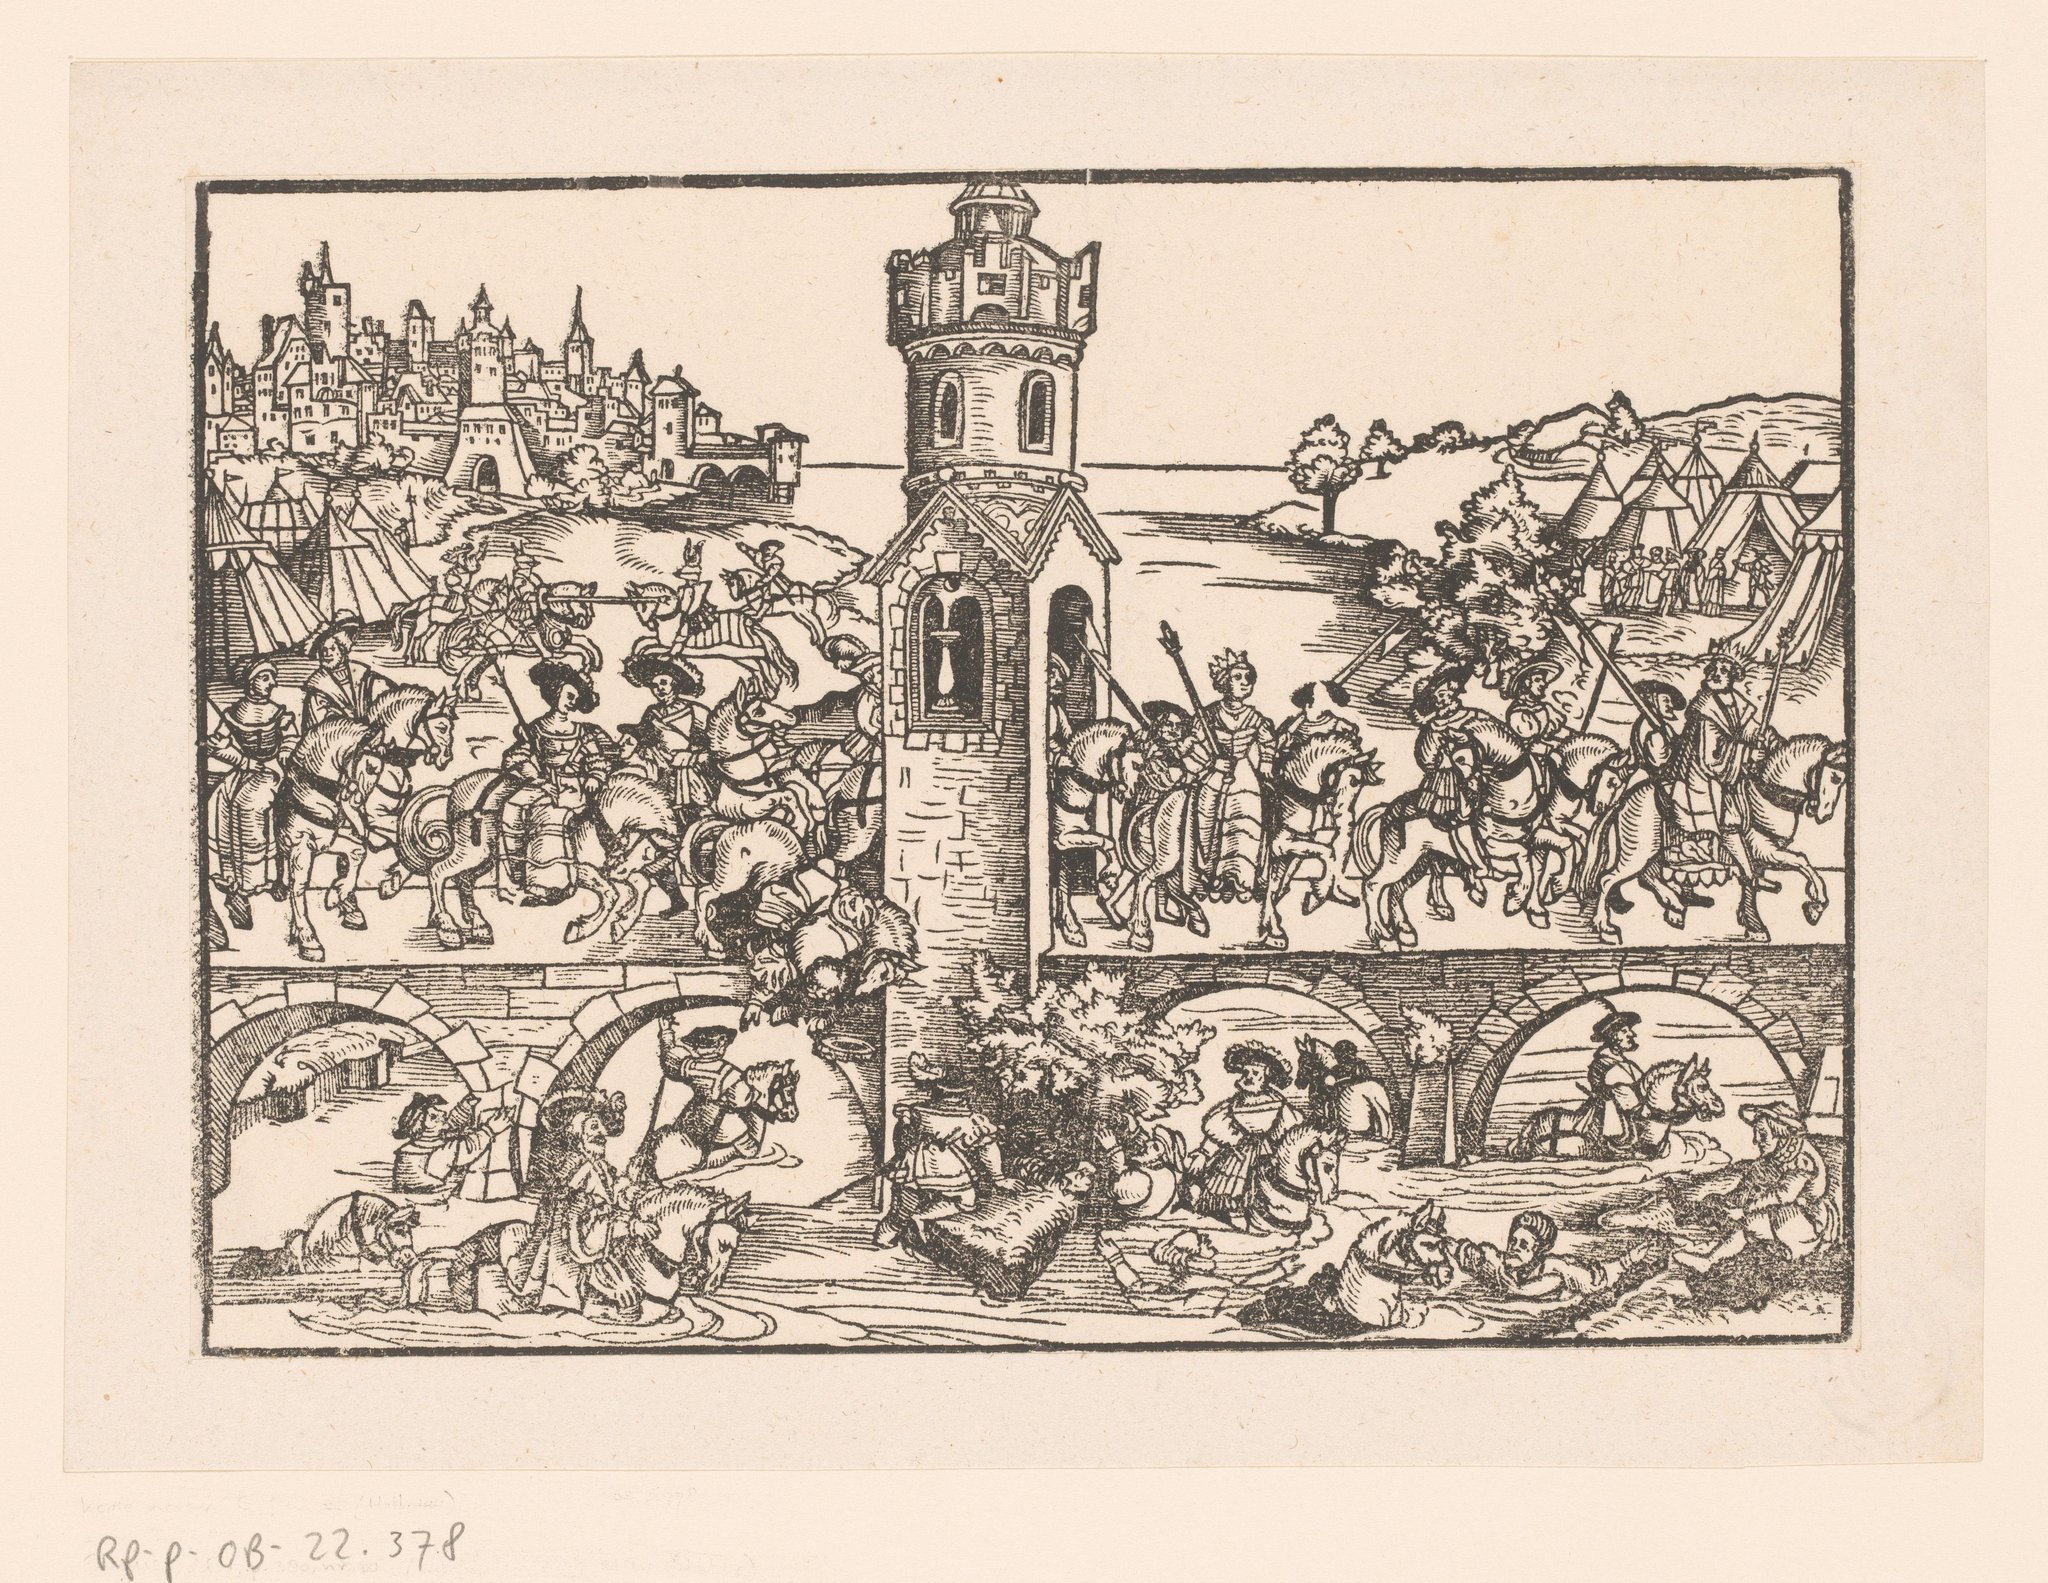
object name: print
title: Brug van overspel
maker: Anonymous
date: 1530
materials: paper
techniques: woodcut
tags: cheat, deceit; 'fraude', 'inganno' (ripa), adultery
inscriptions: collector's mark: Lugt 240